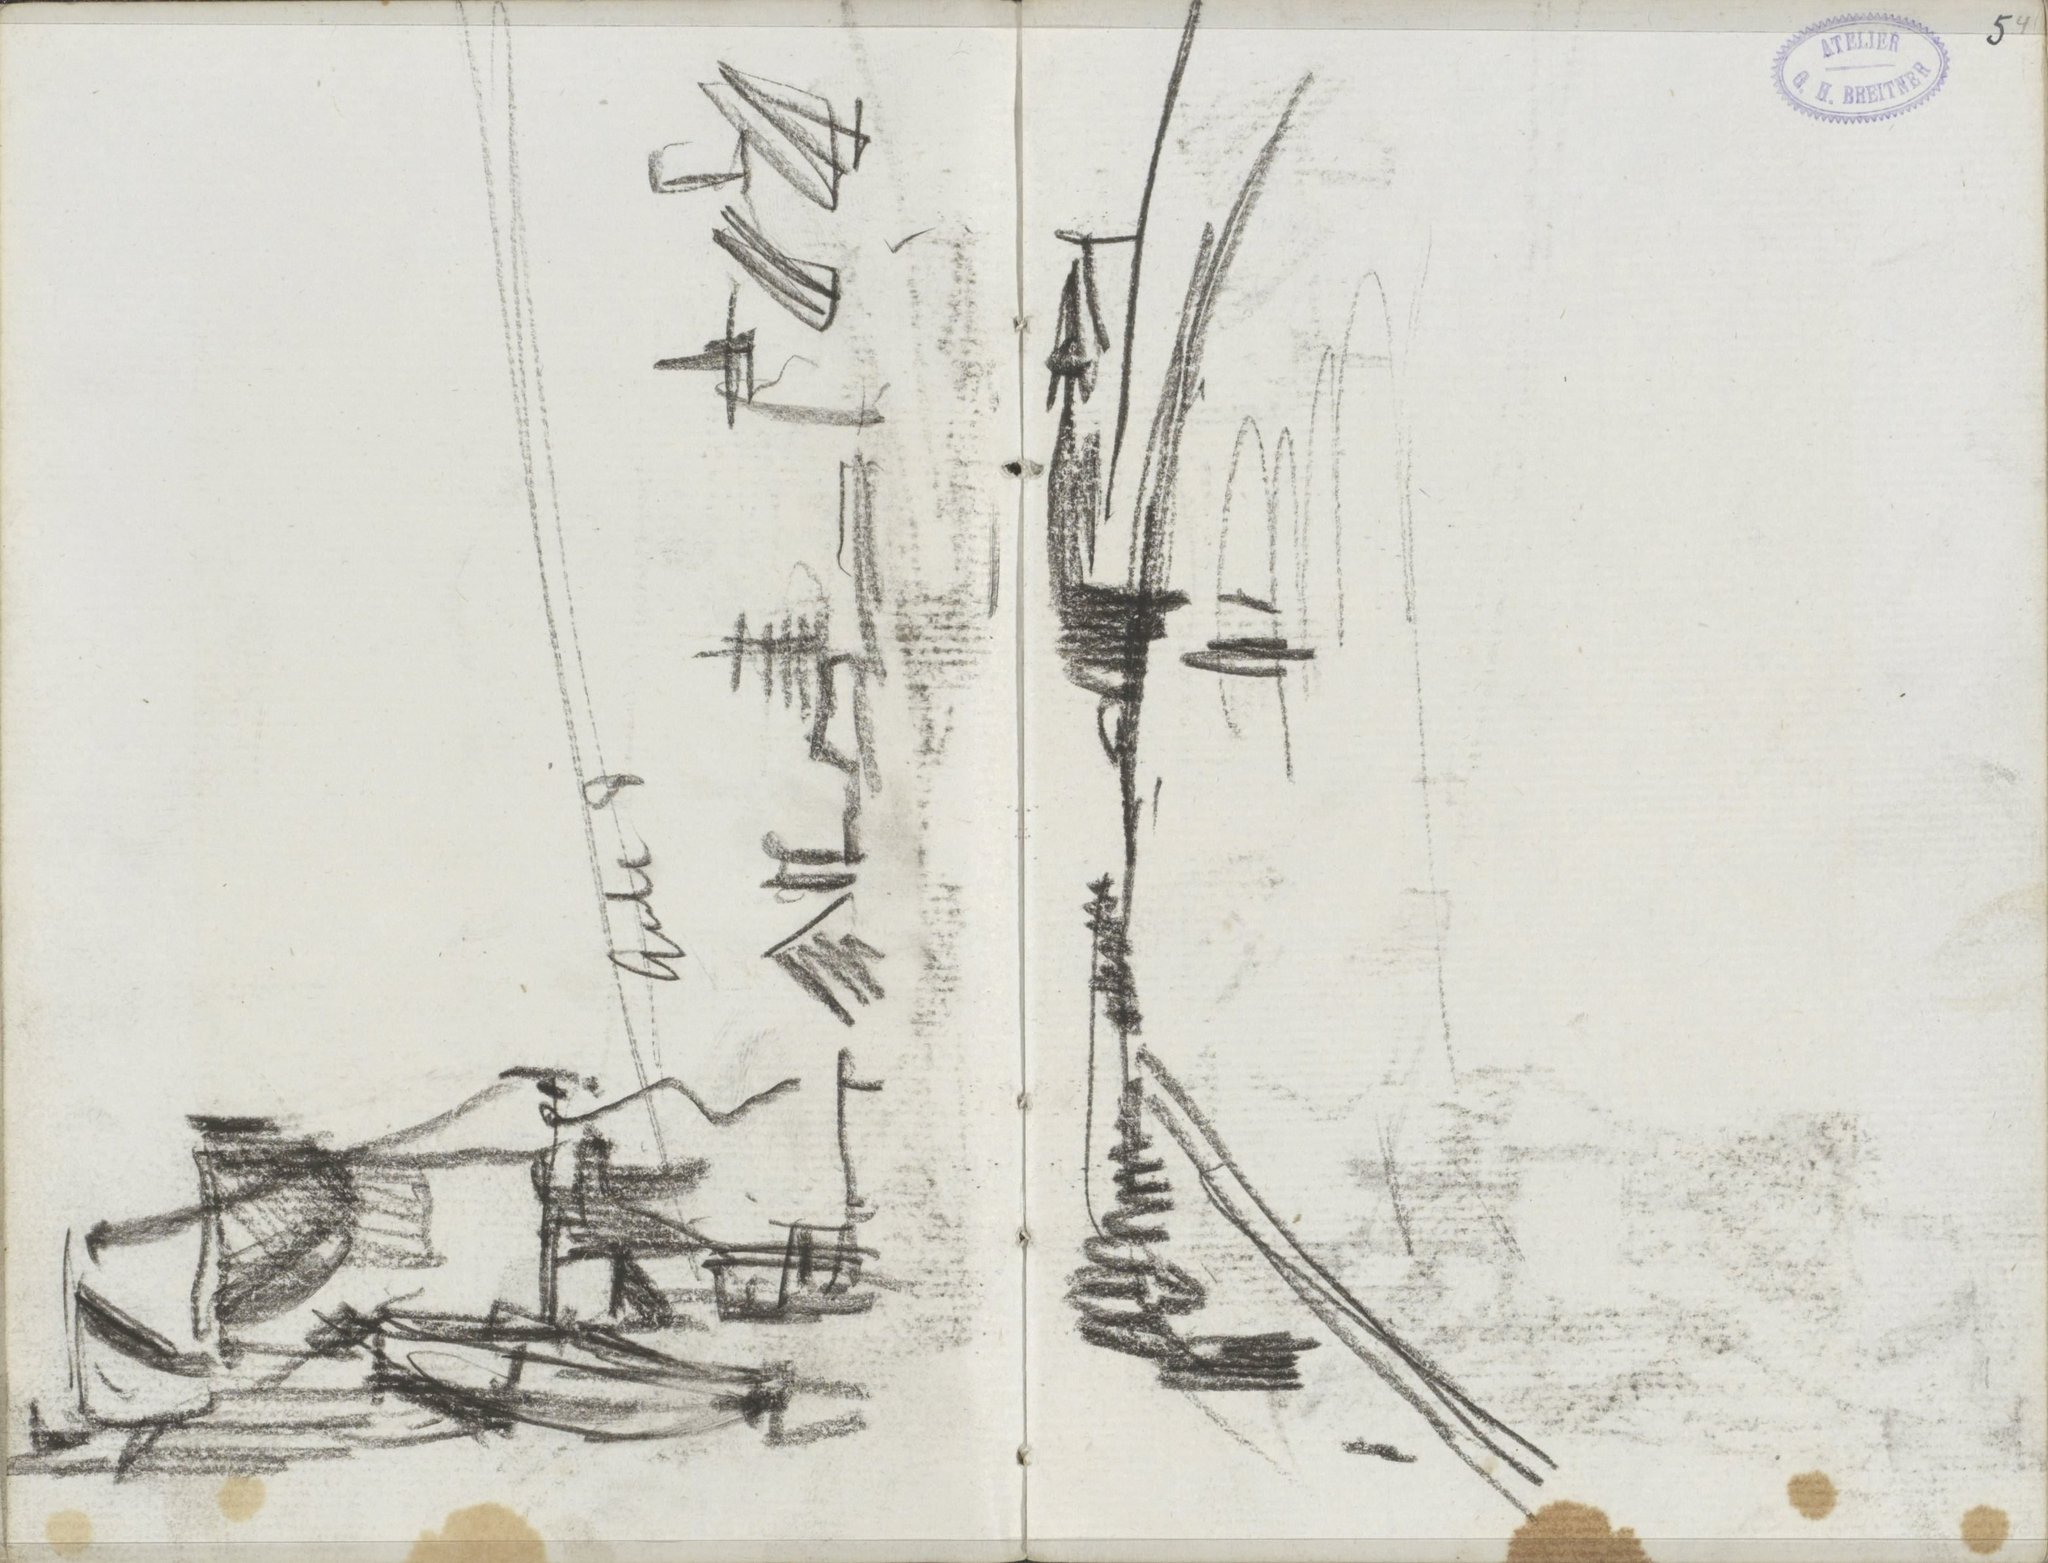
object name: sketchbook leaf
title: Gezicht in Amsterdam, mogelijk het Rokin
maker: george hendrik breitner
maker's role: draughtsman, painter, print maker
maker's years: 1857-1923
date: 1891-1894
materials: chalk, paper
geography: amsterdam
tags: city-view, and landscape with man-made constructions, civic architecture; edifices; dwellings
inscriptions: workshop stamp: Lugt 291d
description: Pagina 4 en pagina 4A uit een schetsboek met 15 bladen.